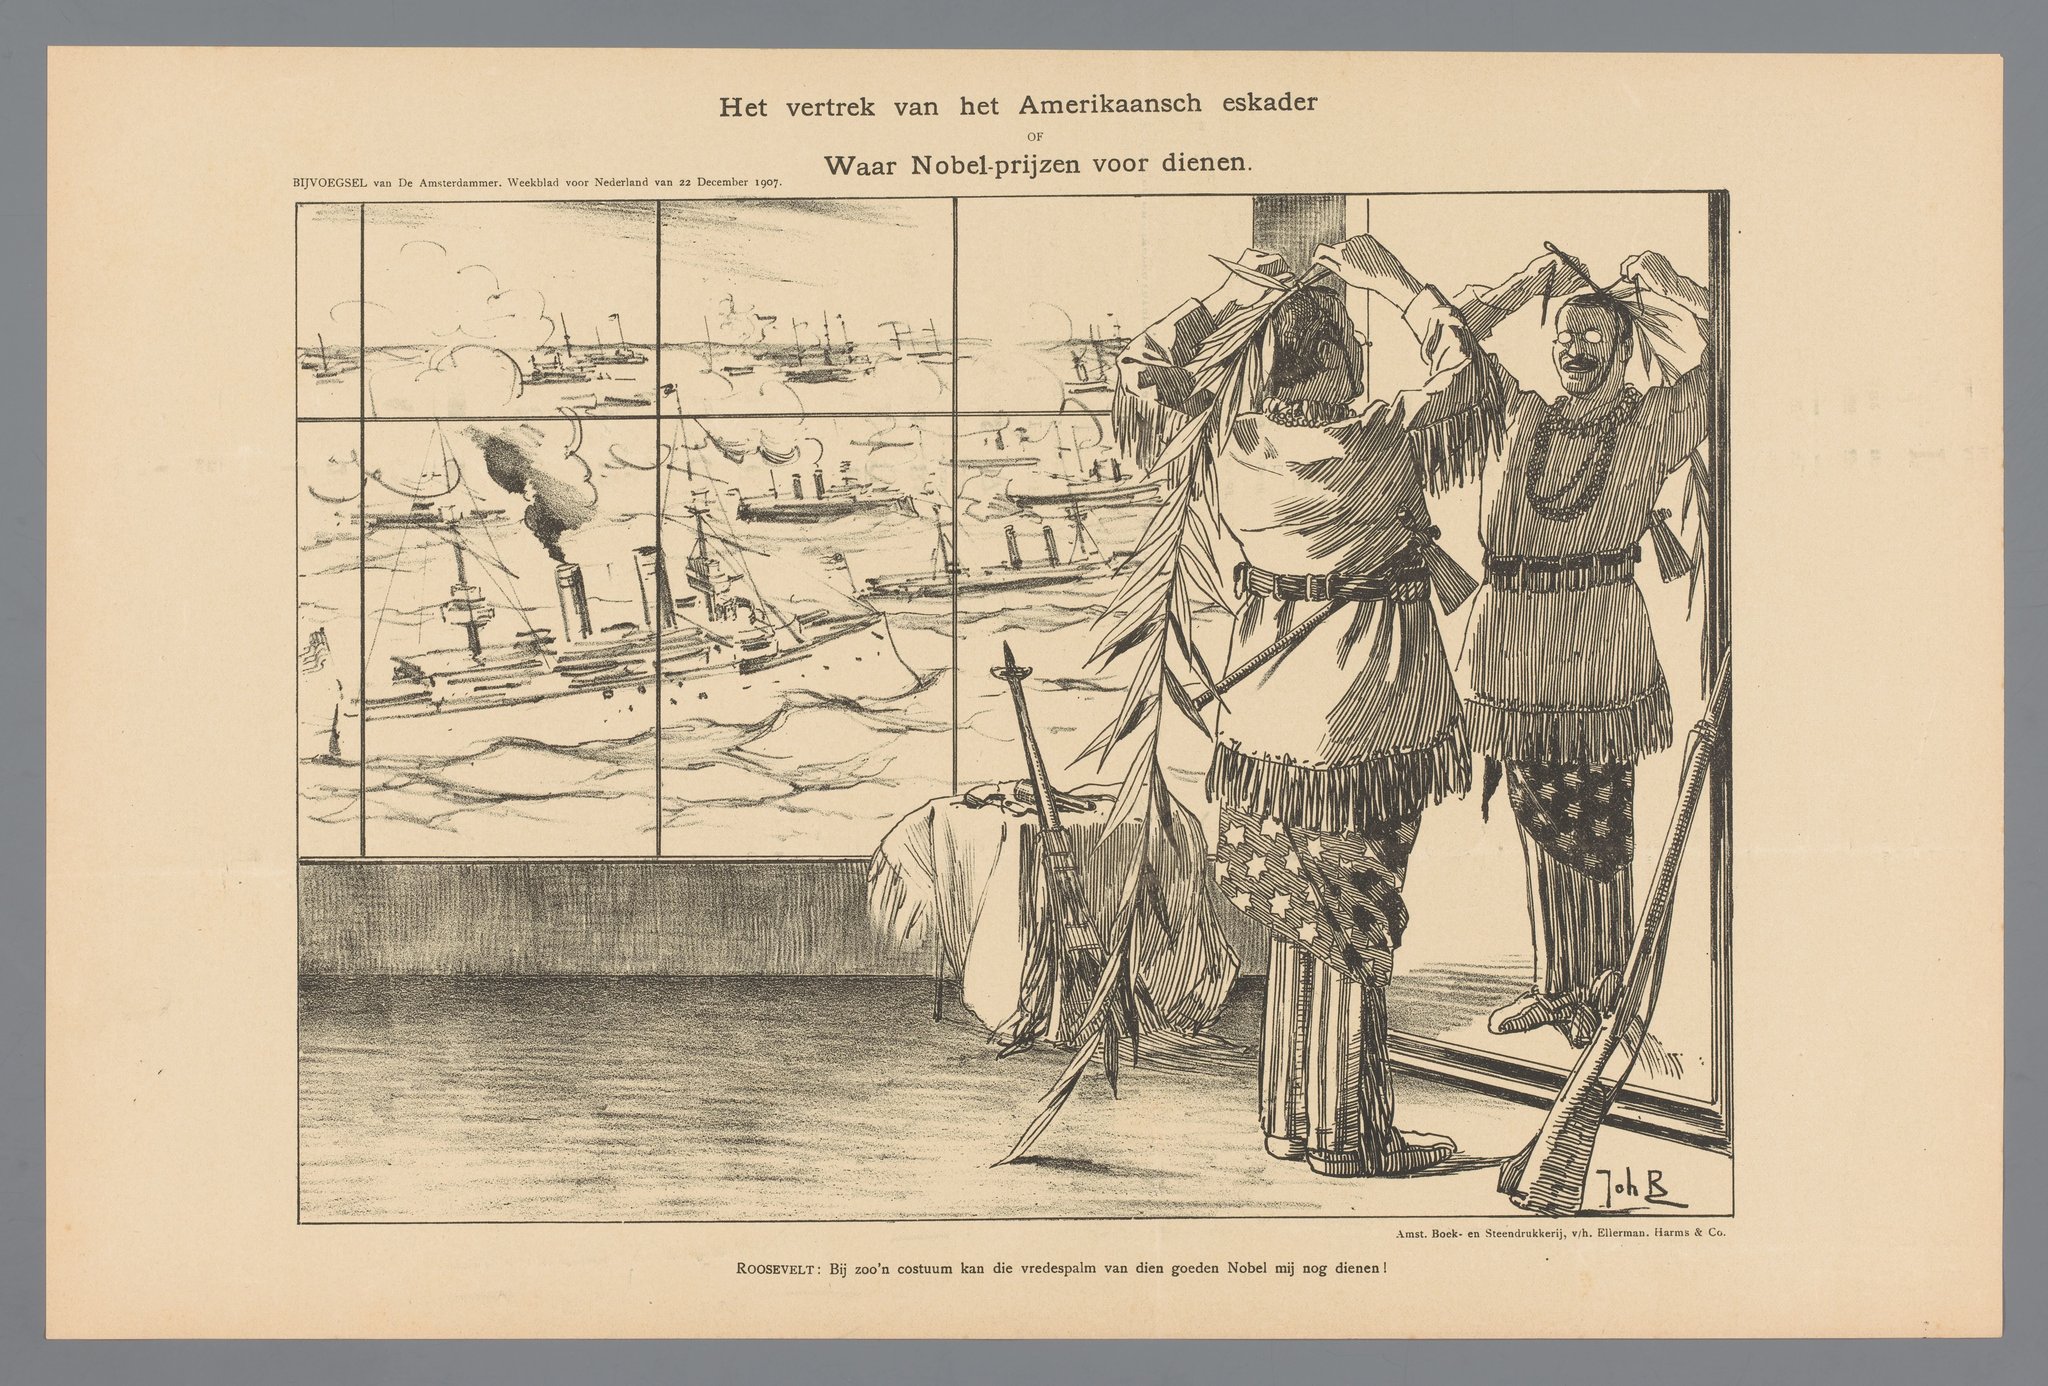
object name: cartoon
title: Het vertrek van het Amerikaansch eskader of Waar Nobel-prijzen voor dienen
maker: johan braakensiek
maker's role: draughtsman, print maker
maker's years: 1858-1940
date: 1907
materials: paper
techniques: lithograph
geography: amsterdam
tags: new york (city), politician, symbols, allegories of peace, 'pax'; 'pace' (ripa), president ~ head of republic, historical persons, navy, political caricatures and satires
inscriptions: date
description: Prent uit het bijvoegsel van: De Amsterdammer. Weekblad voor Nederland, 22 december 1907.